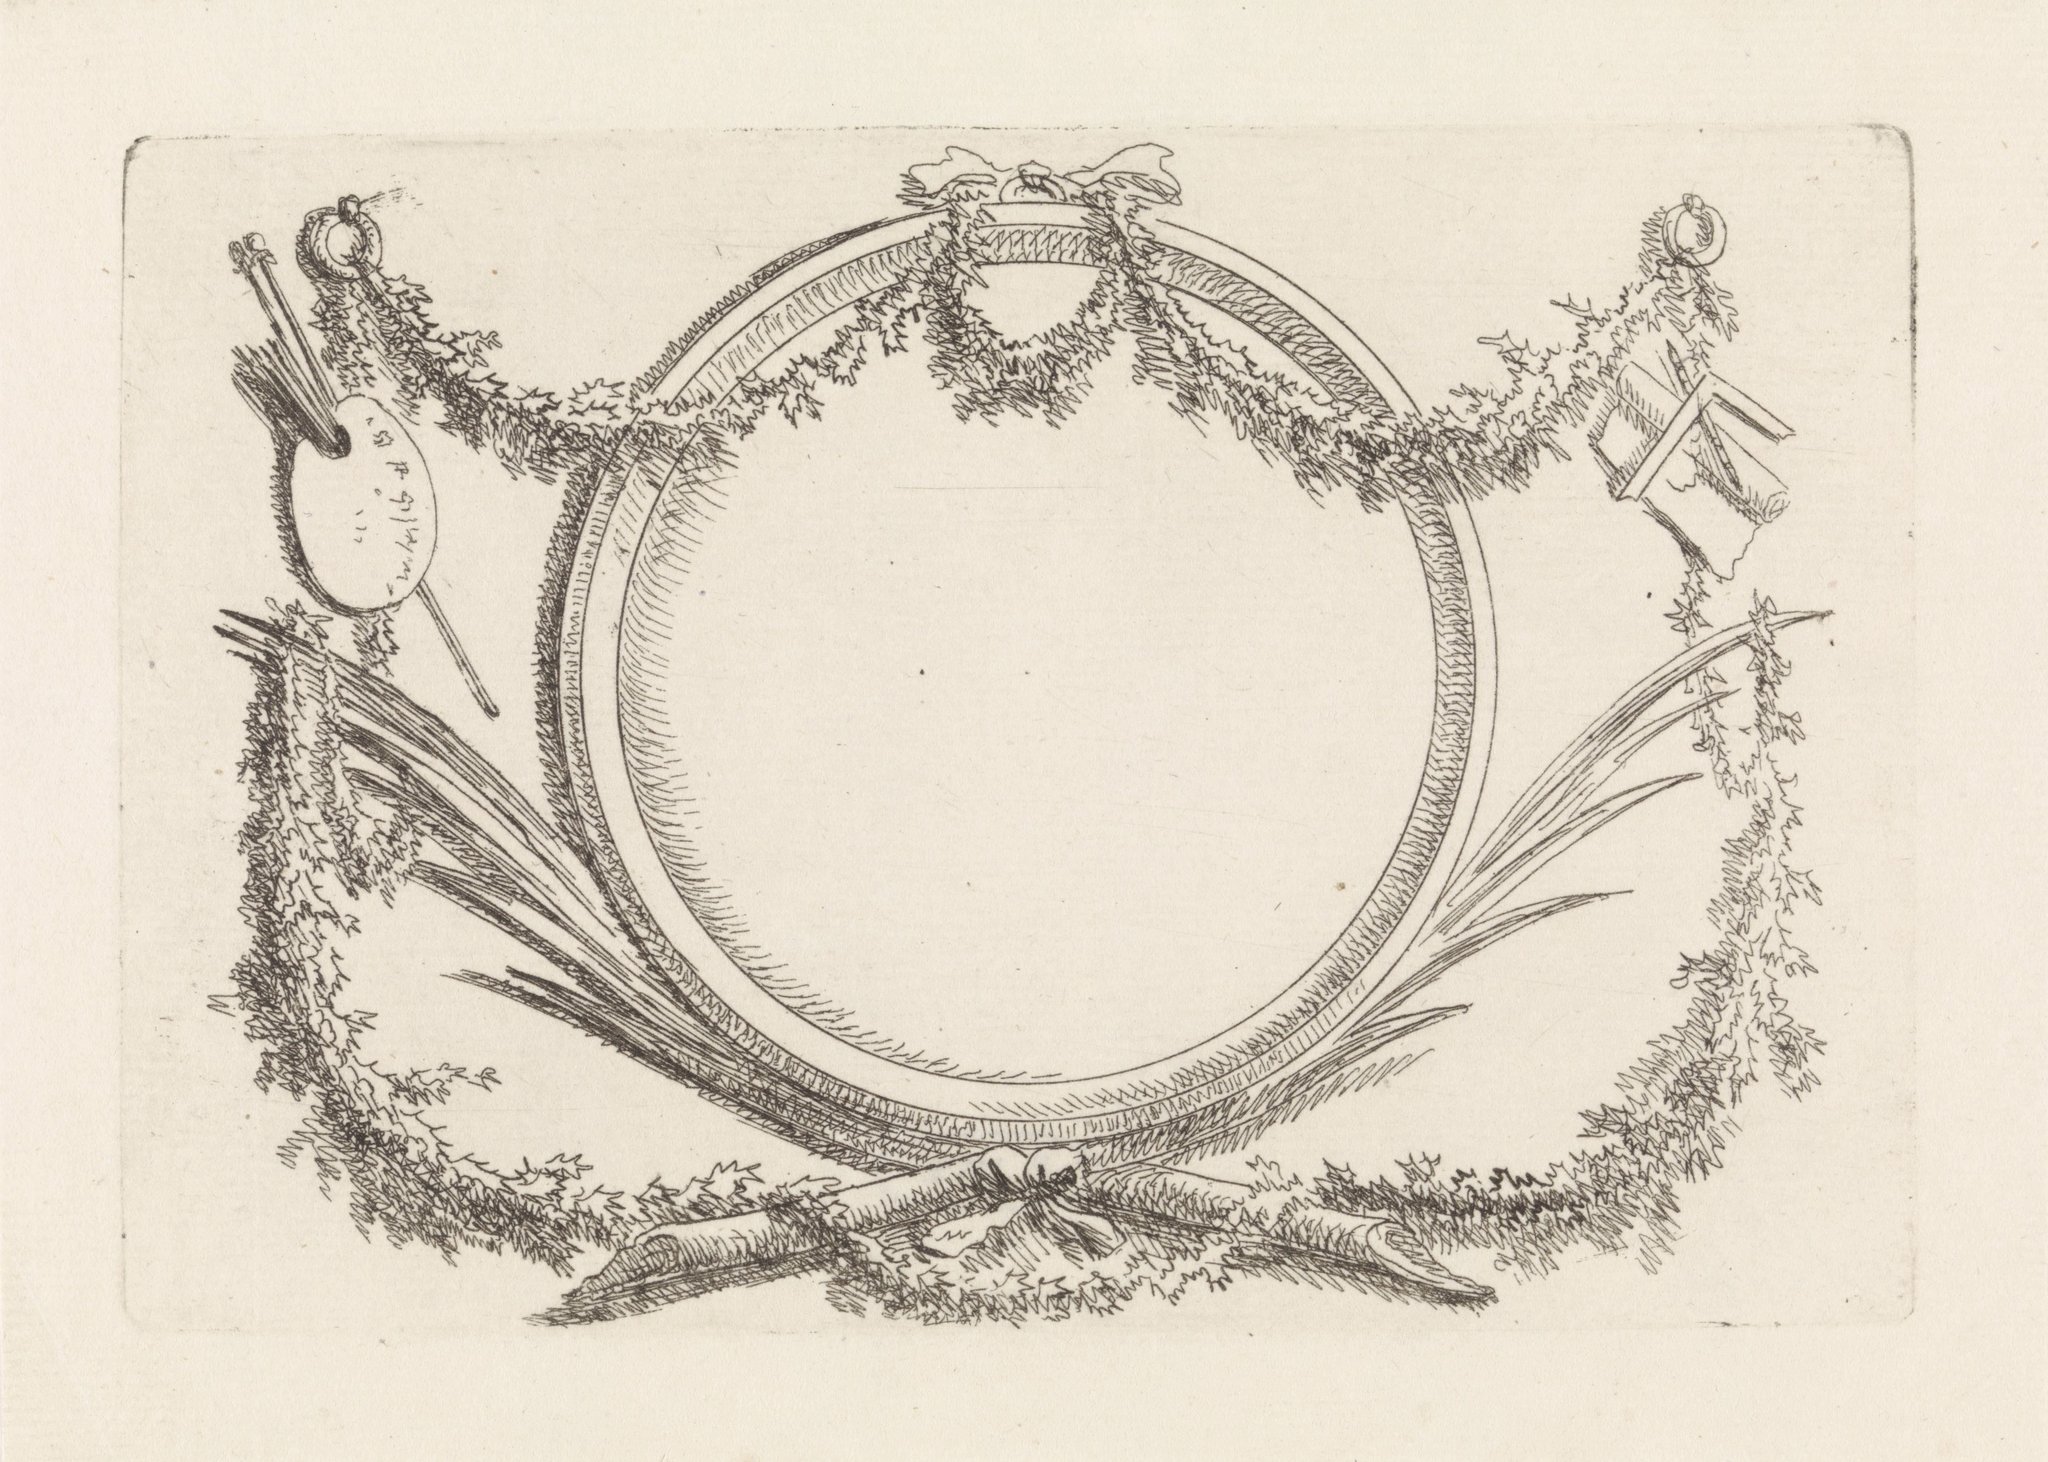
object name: print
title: Ornamentele omlijsting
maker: gerard van nijmegen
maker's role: draughtsman, painter, print maker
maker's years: 1735-1808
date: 1745-1808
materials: paper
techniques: etching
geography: rotterdam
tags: palette, pencil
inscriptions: collector's mark: Lugt 2228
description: Ornamentele omlijsting met links een palet met penselen en schilderstok en rechts een pen en papier.